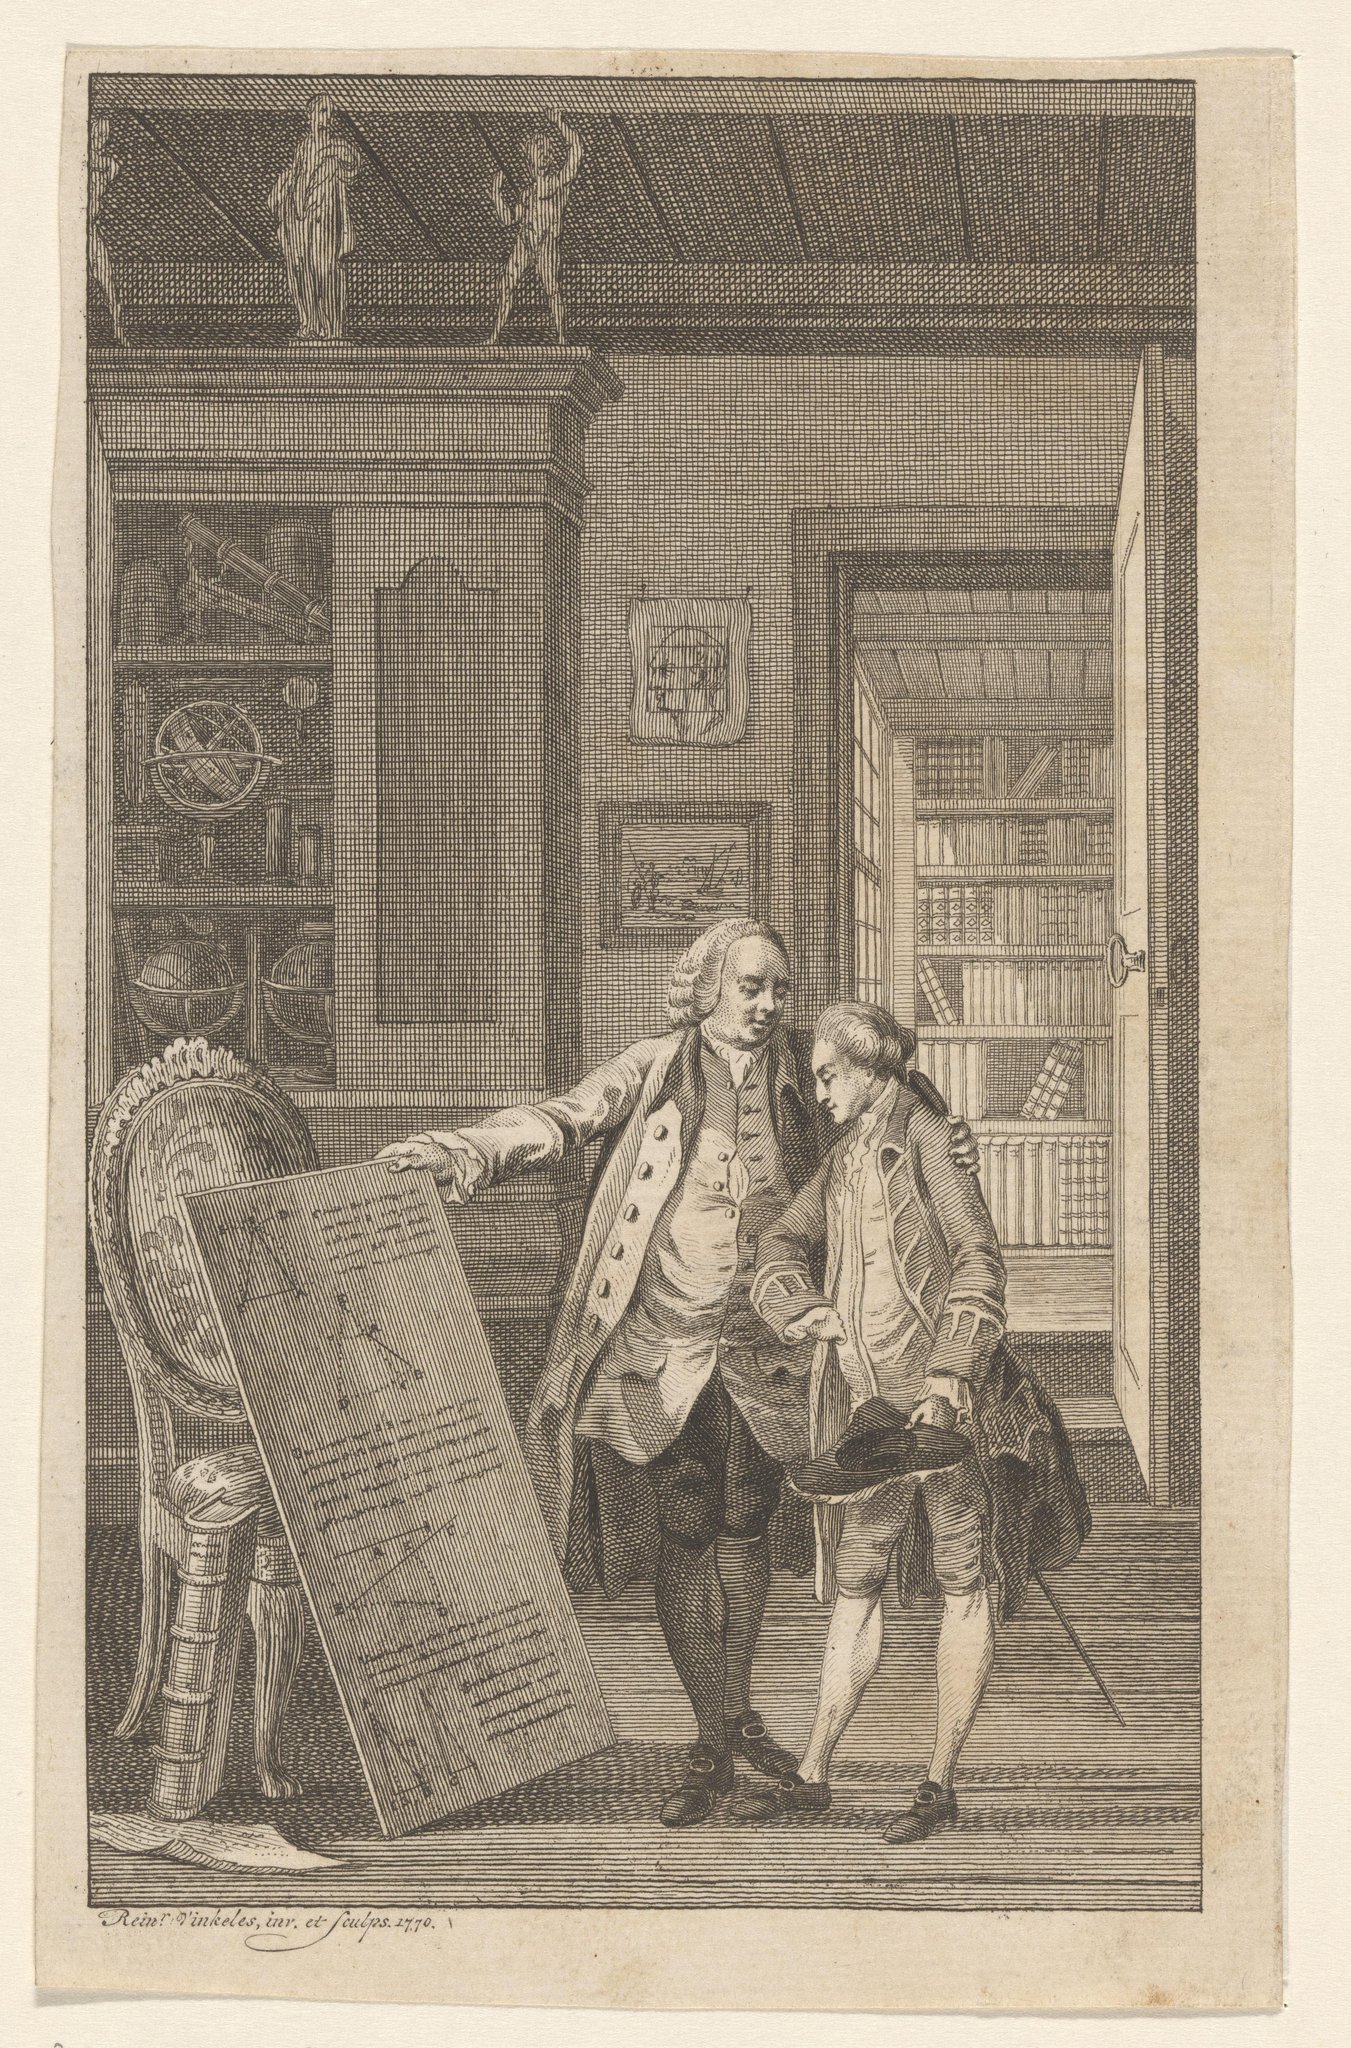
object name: print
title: Meetkunde les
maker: reinier vinkeles (i)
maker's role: draughtsman, print maker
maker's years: 1741-1816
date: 1770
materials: paper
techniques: etching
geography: amsterdam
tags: bookshelves, scholar in his study, planimetry, geometry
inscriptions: collector's mark: Lugt 2228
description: Een oudere man toont een jongere man, wellicht zijn zoon, een bord met geometrische tekeningen en tekst. In een studeerkamer met wetenschappelijke instrumenten, door de openstaande deur zicht op een boekenkast.